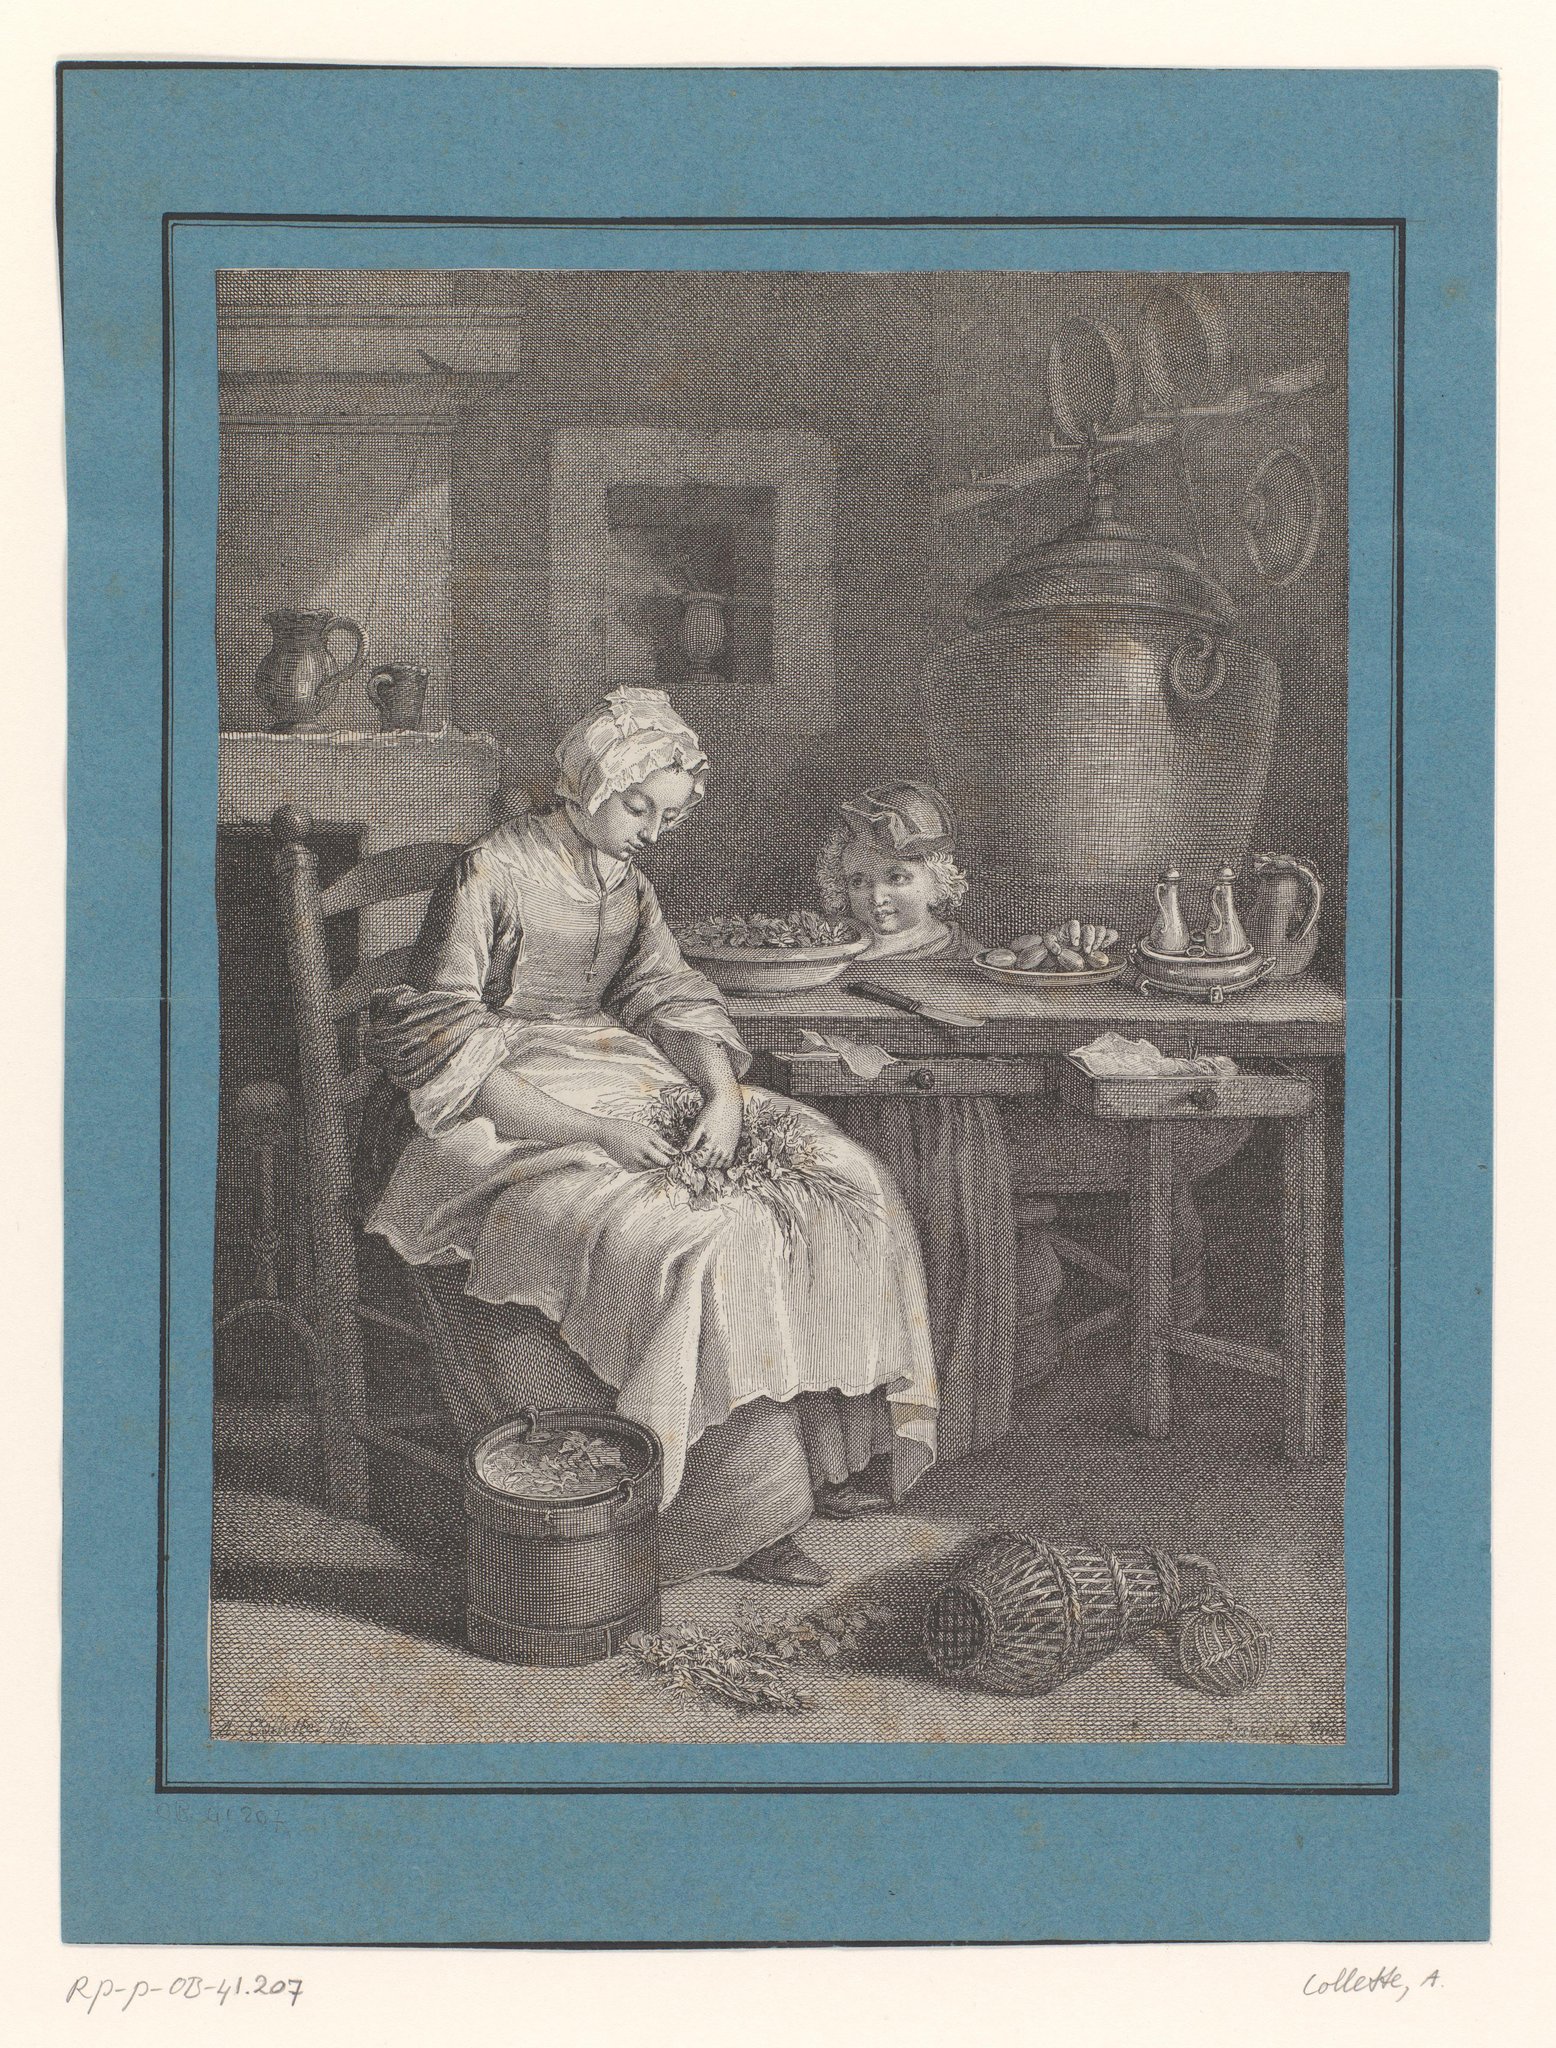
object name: print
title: Keukeninterieur met vrouw en kind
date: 1836-1869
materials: paper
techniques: lithograph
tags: garland, wreath, kitchen-interior, kitchen-maid, kitchen servant, child (at home)